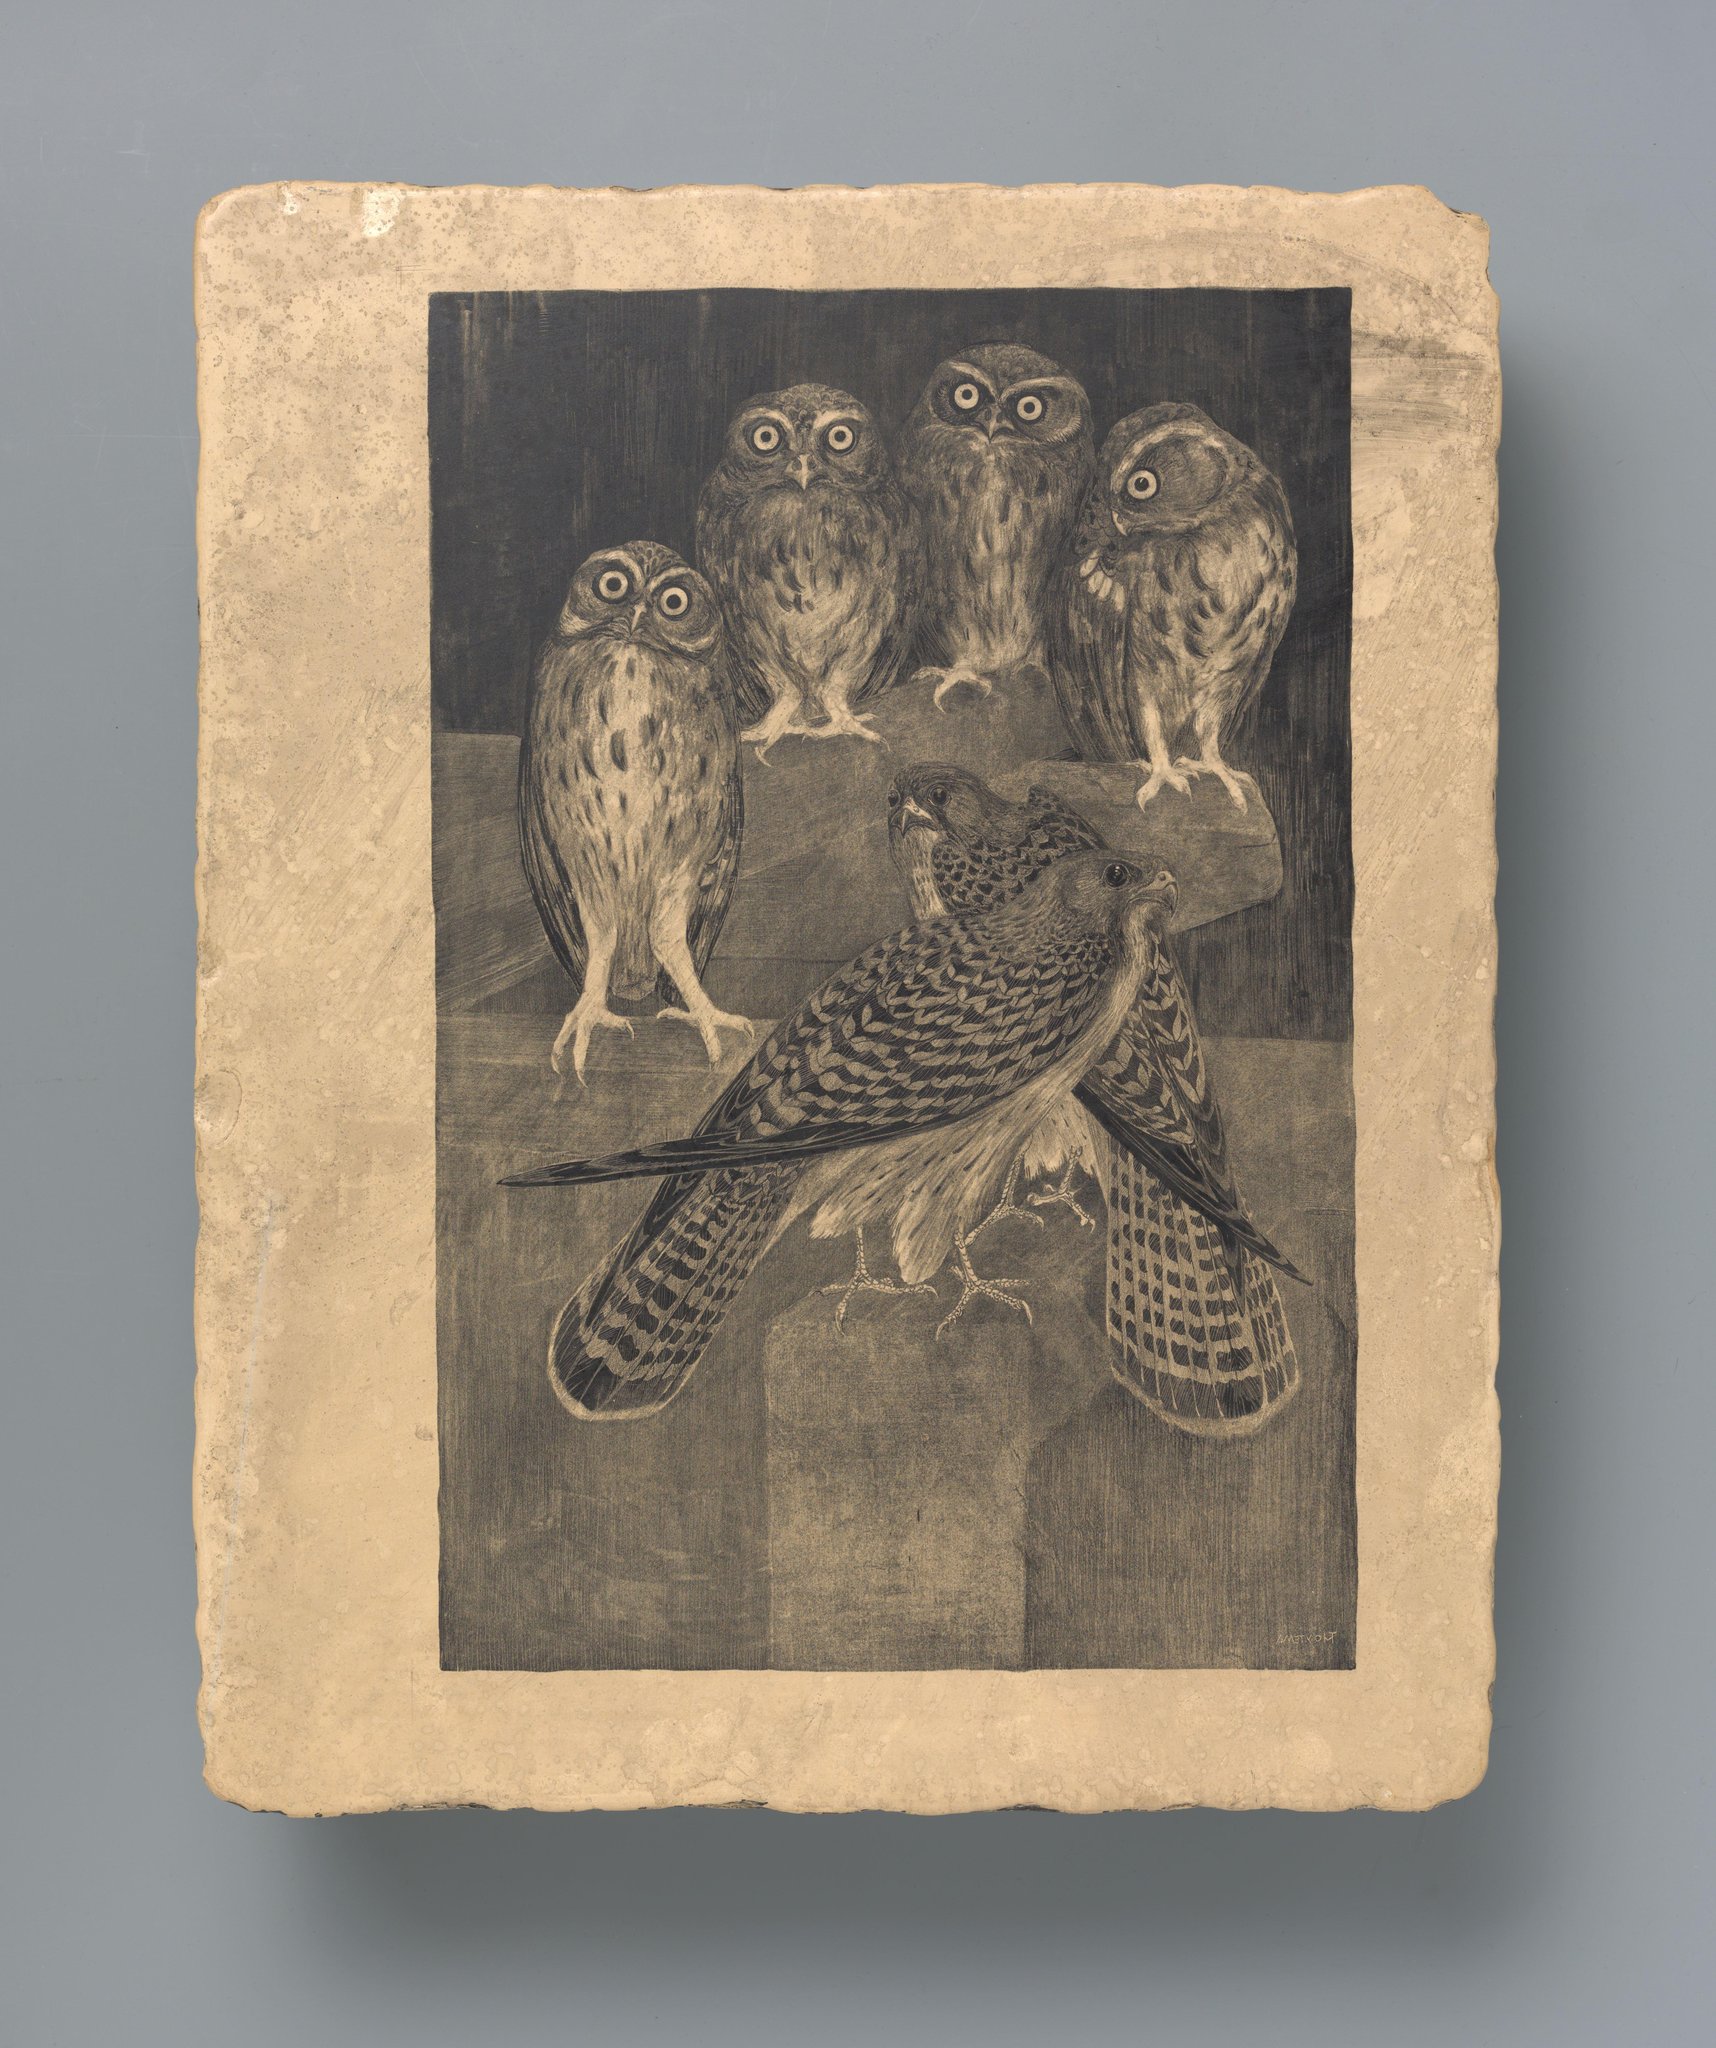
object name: lithographic stone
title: Steenuilen en torenvalken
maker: theo van hoytema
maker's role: draughtsman, painter, print maker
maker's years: 1863-1917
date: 1873-1917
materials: stone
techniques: blind stamped, lithograph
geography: netherlands